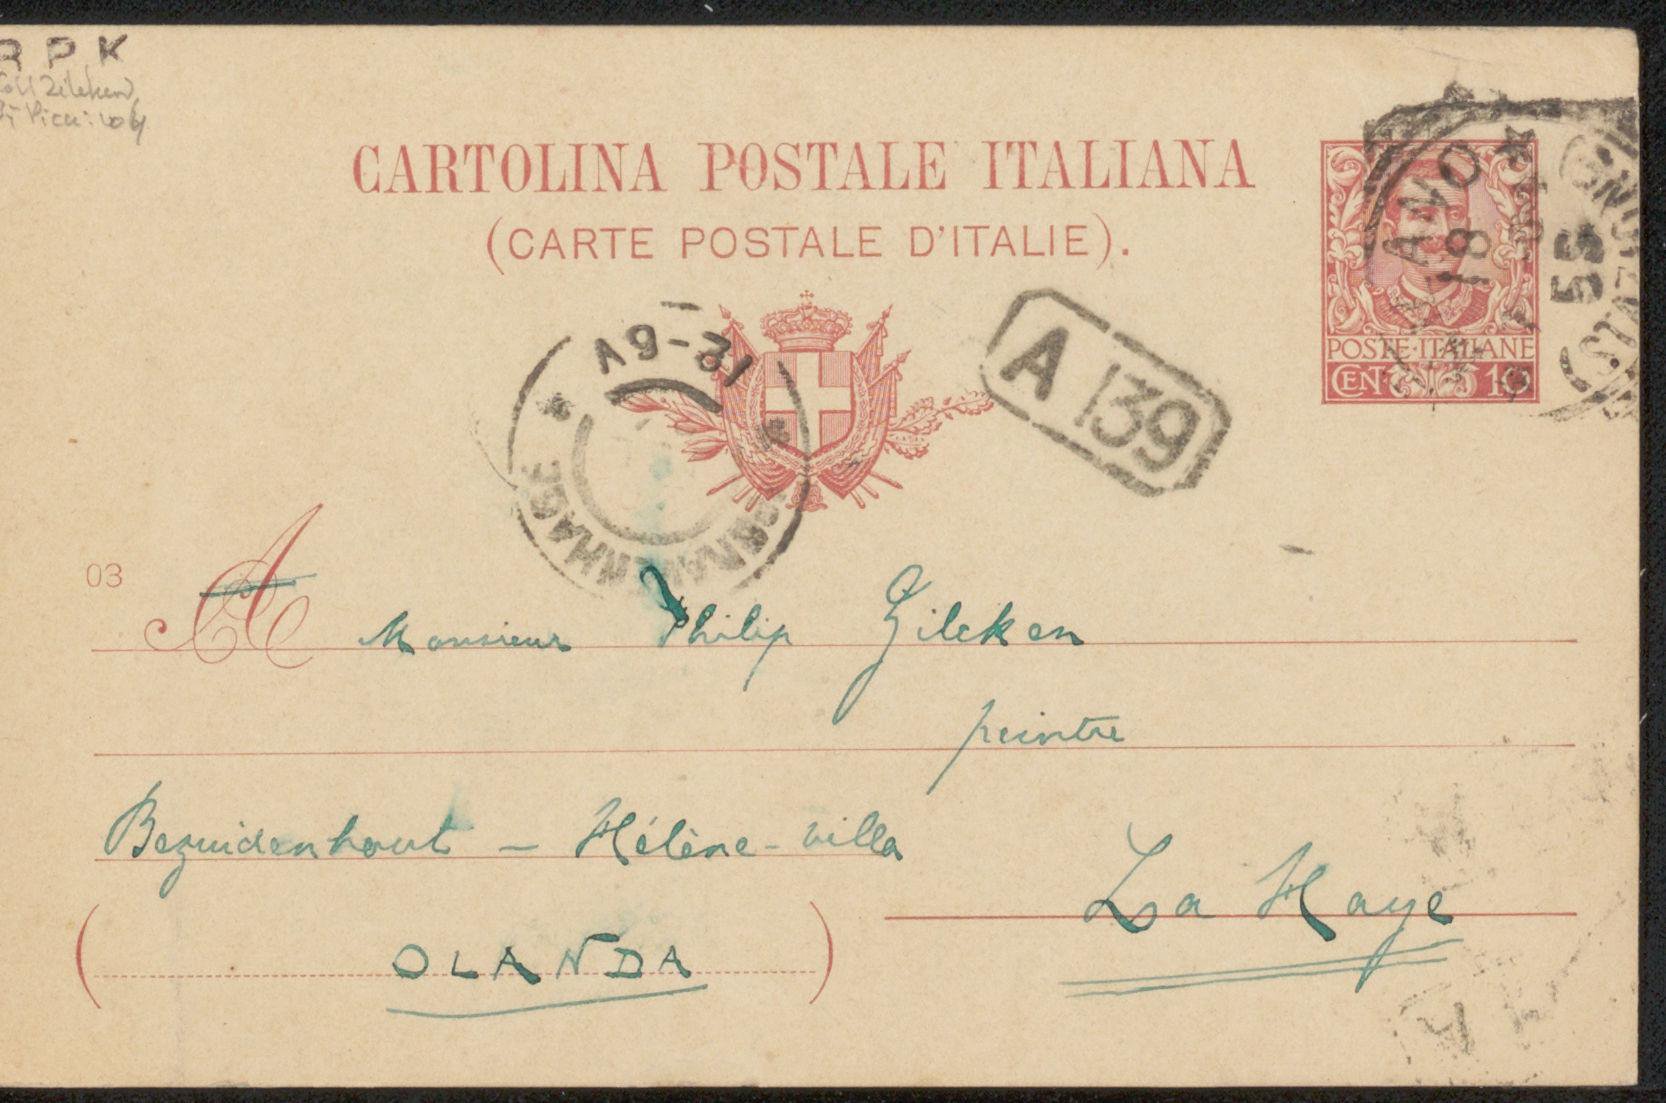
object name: postcard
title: Briefkaart aan Philip Zilcken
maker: vittorio pica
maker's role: criticus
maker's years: 1864-1930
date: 1904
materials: cardboard, ink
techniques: pen, writing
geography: milan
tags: liège, painter, print maker, draughtsman, armand rassenfosse, carel nicolaas storm van 's-gravesande, etienne bosch, albrecht felix reicher, the hague, philip zilcken, photography, cinematography, the graphic arts, printed matter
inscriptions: collector's mark: ‘RPK’